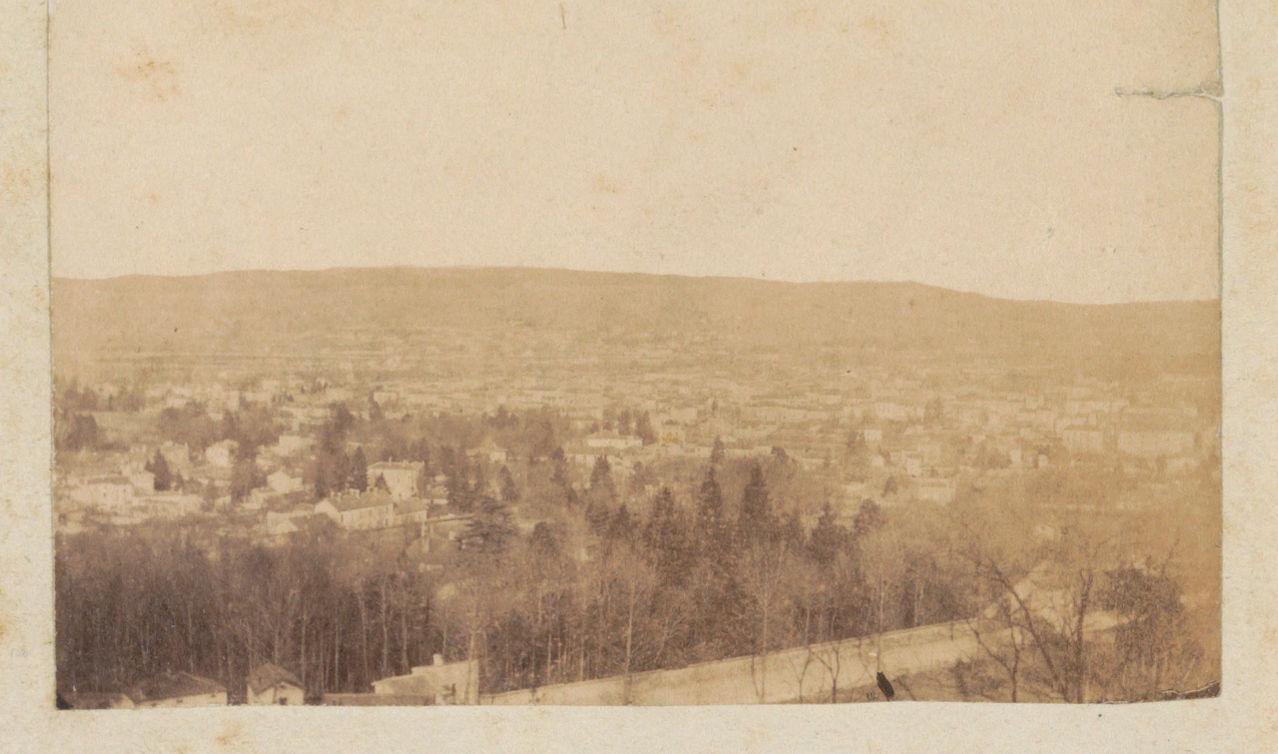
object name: photograph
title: Gezicht op een stad, vermoedelijk in Frankrijk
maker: Anonymous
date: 1883-1886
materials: photographic support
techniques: albumen print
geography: france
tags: prospect of city, town panorama, silhouette of city, france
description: Mogelijk was deze foto bedoeld als panorama samen met RP-F-2007-66-58-3. Onderdeel van Album van een Franse amateurfotograaf met opnames van familie, militairen, industrie, landschappen en bezienswaardigheden in Frankrijk.